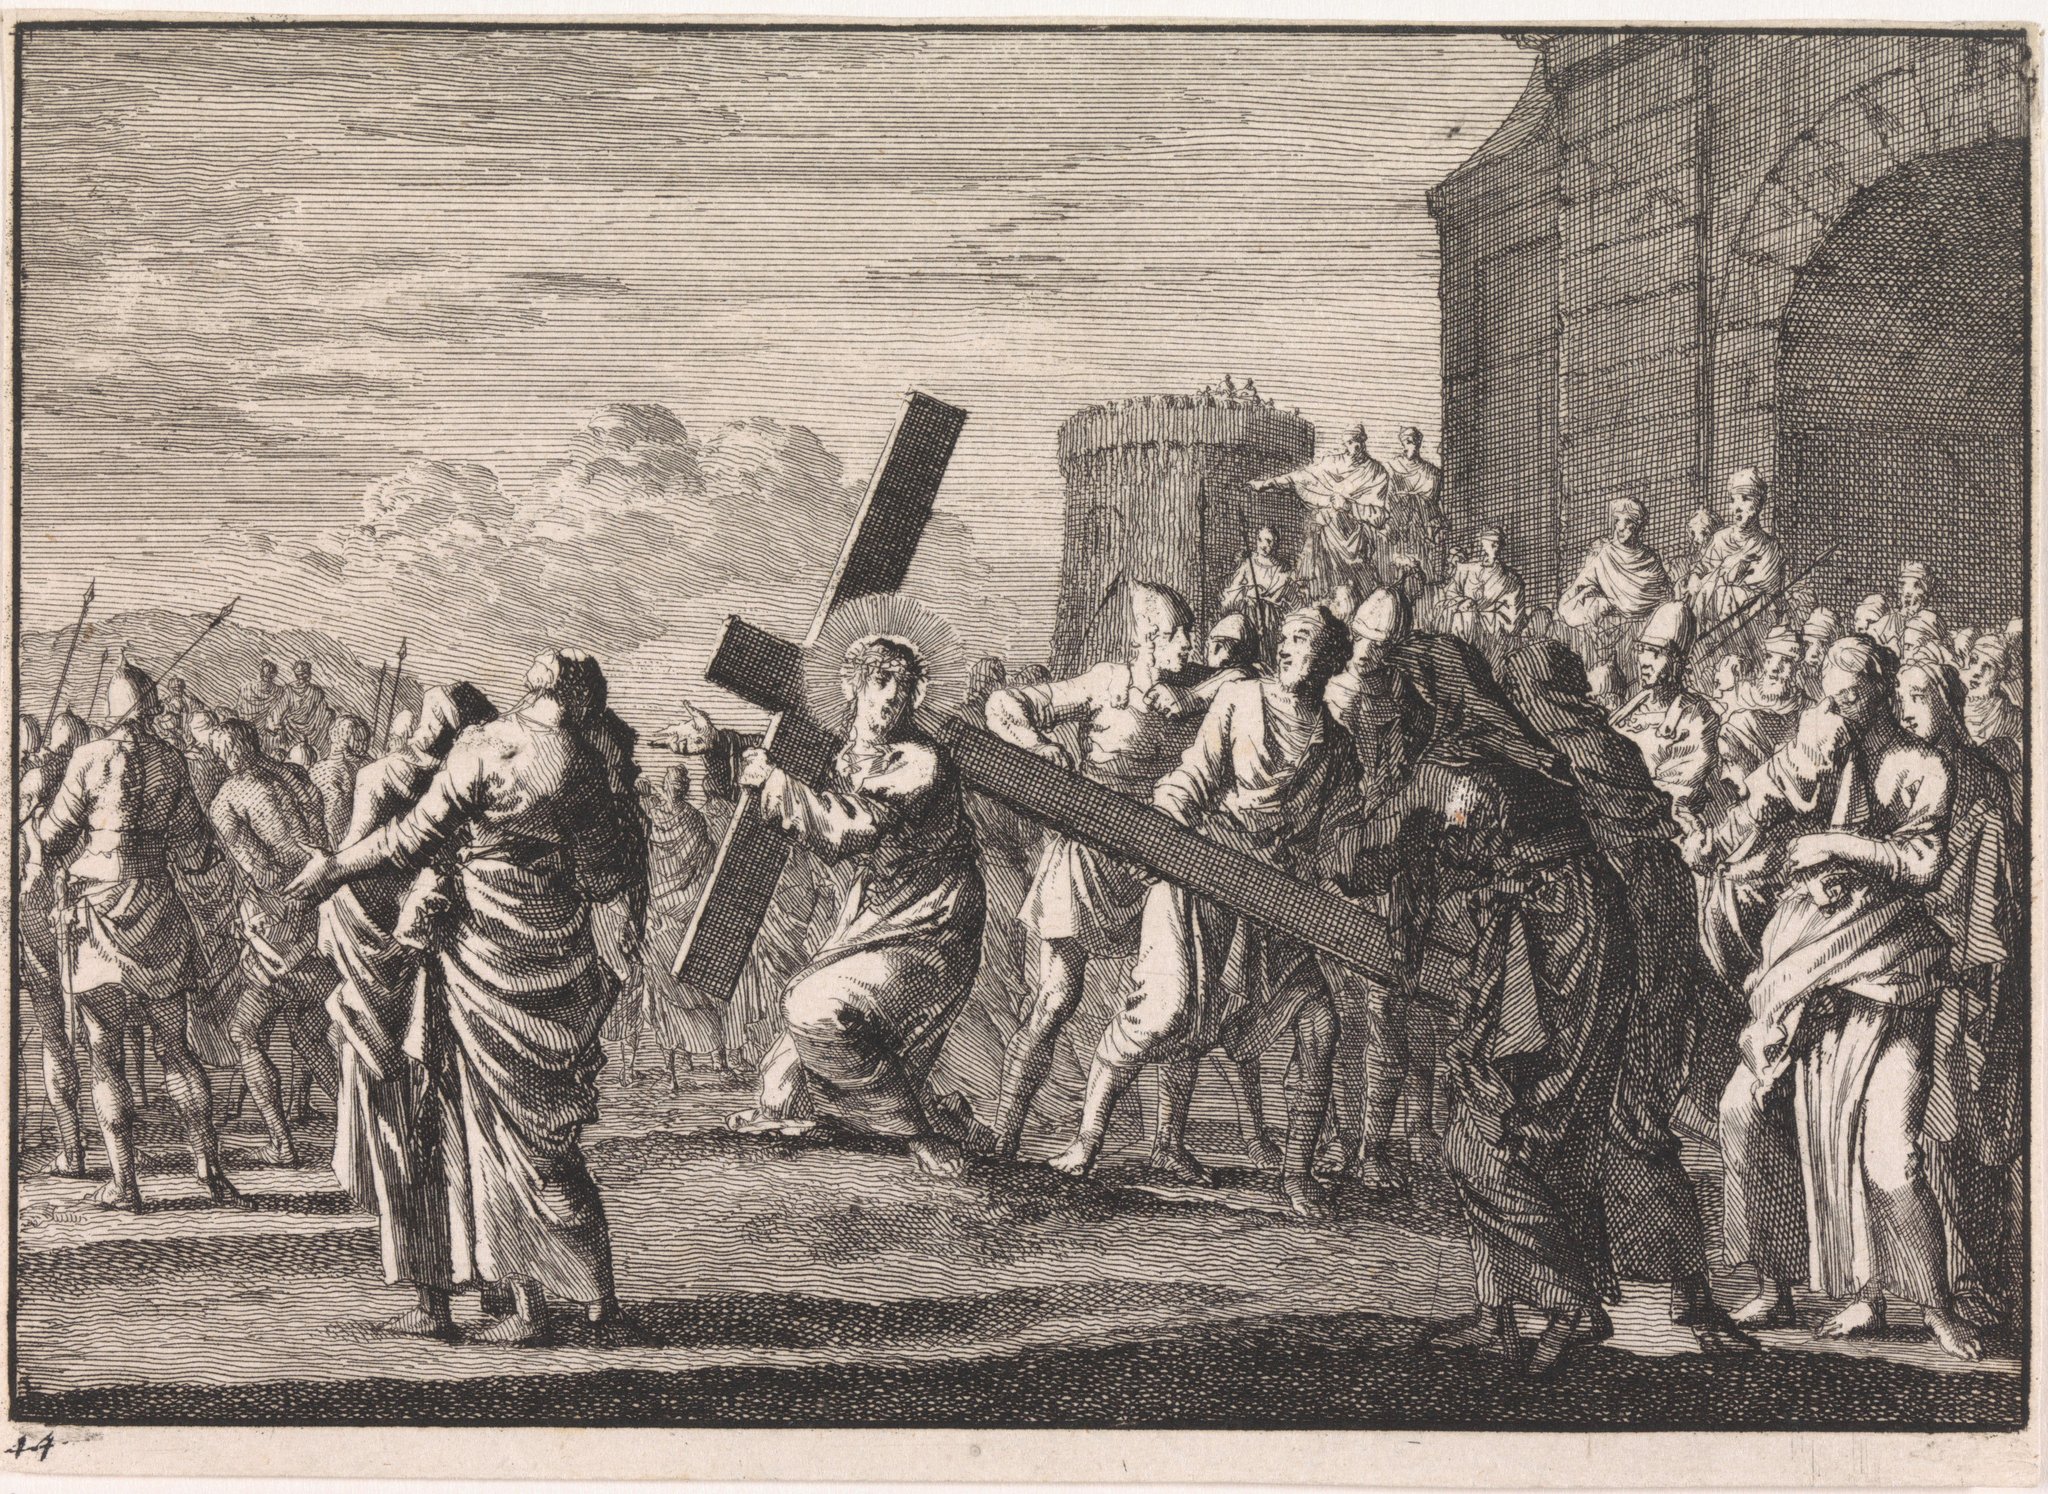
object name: print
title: Kruisdraging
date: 1703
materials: paper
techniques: etching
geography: amsterdam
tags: carrying of the cross: christ bearing the cross, alone or with the help of others (e.g. simon the cyrenian)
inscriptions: collector's mark: Lugt 2228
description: Proefdruk van een boekillustratie voor David Martin. Historie des Ouden en Nieuwen Testaments. Amsterdam, Pieter Mortier, 1703. Deel II. De boekillustraties voor de Mortierbijbel hebben verschillende staten en kopieën, waarbij de chronologische volgorde moeilijk te achterhalen valt. Als boekillustraties werden ze bovendien herhaaldelijk opnieuw gebruikt voor andere boekwerken.